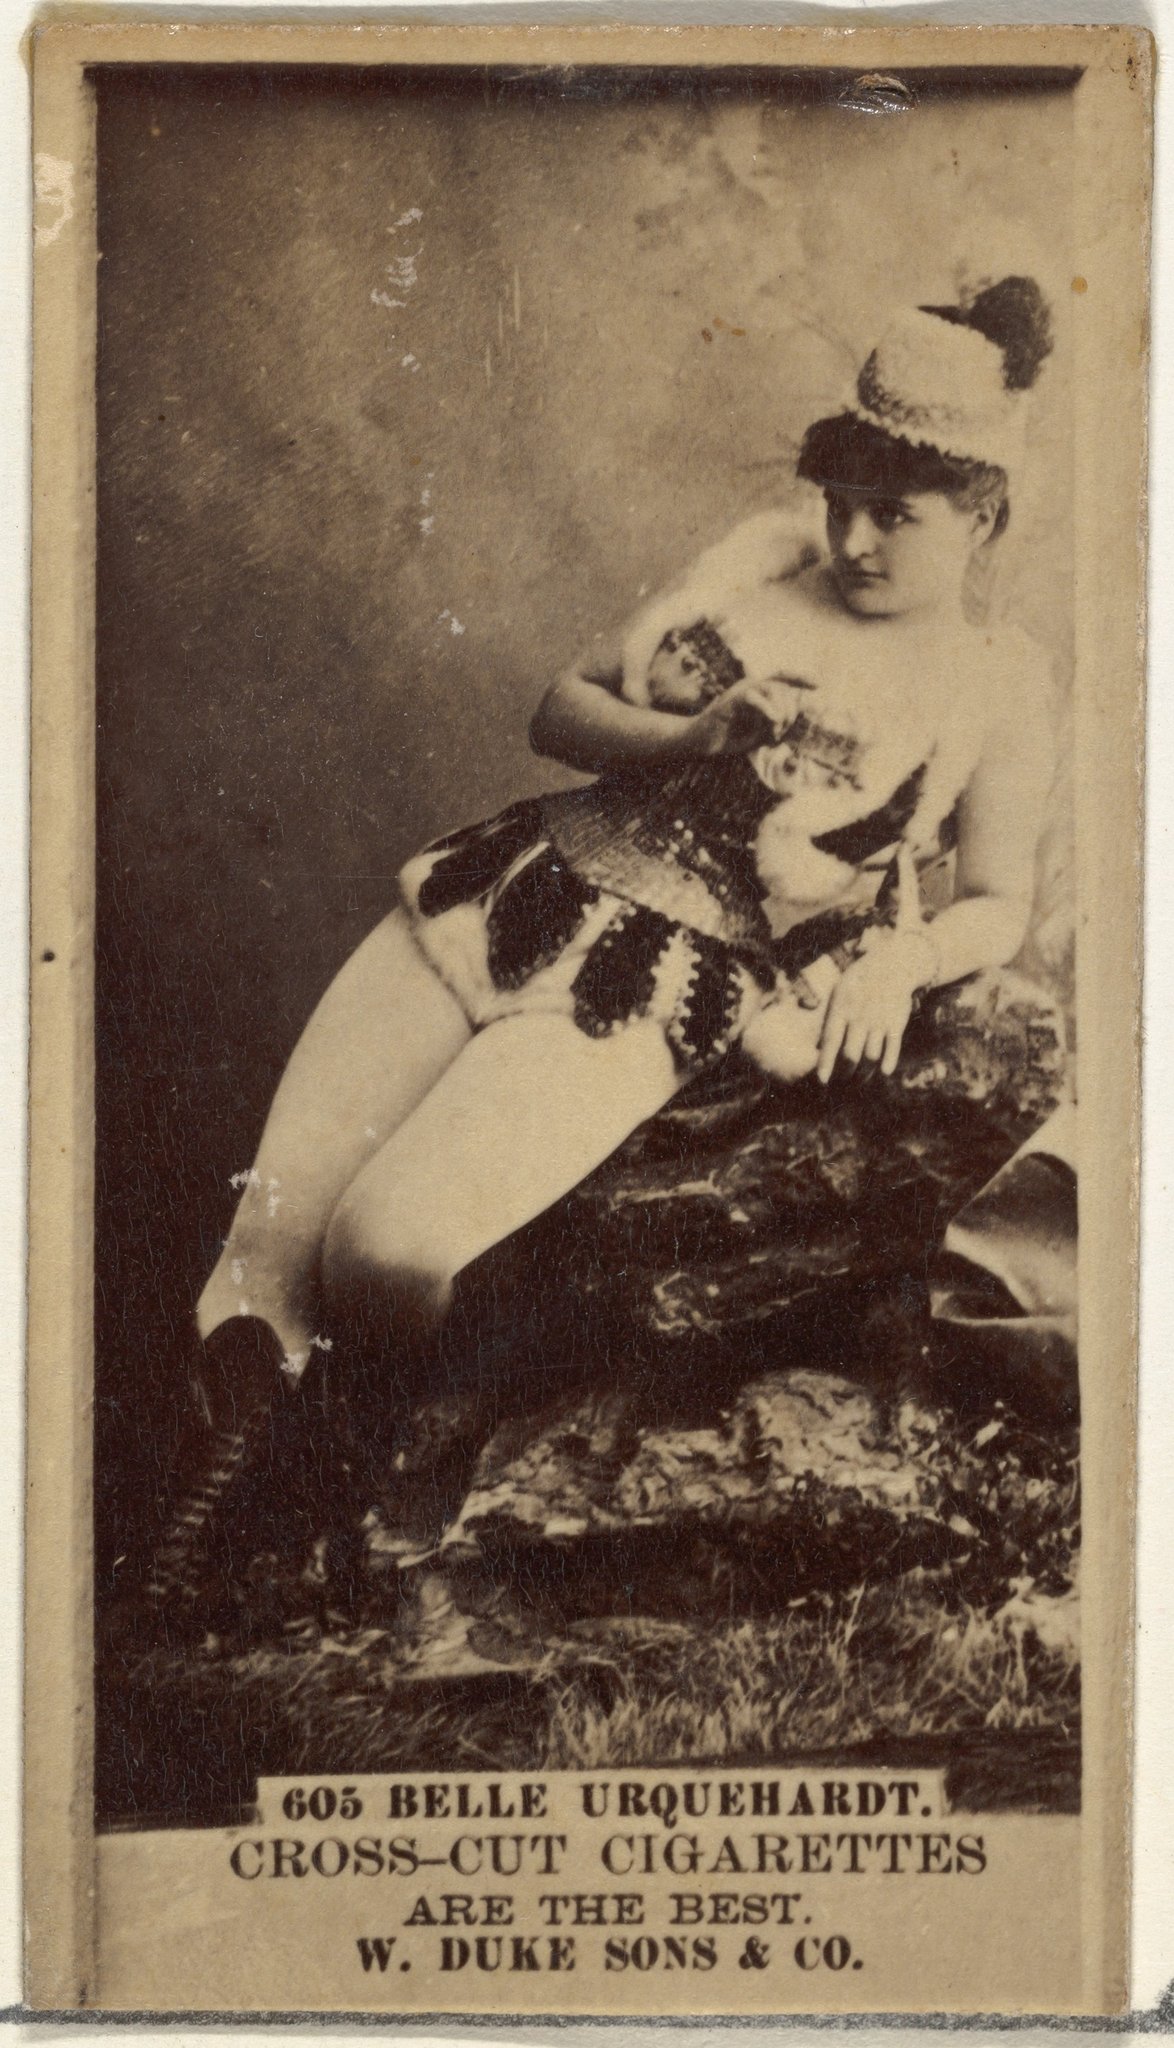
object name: photograph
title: Card Number 605, Belle Urquehardt, from the Actors and Actresses series (N145-3) issued by Duke Sons & Co. to promote Cross Cut Cigarettes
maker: w. duke, sons & co.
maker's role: publisher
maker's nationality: american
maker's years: 1870-1920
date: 1880-1889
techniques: albumen silver print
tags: portraits,women,actresses